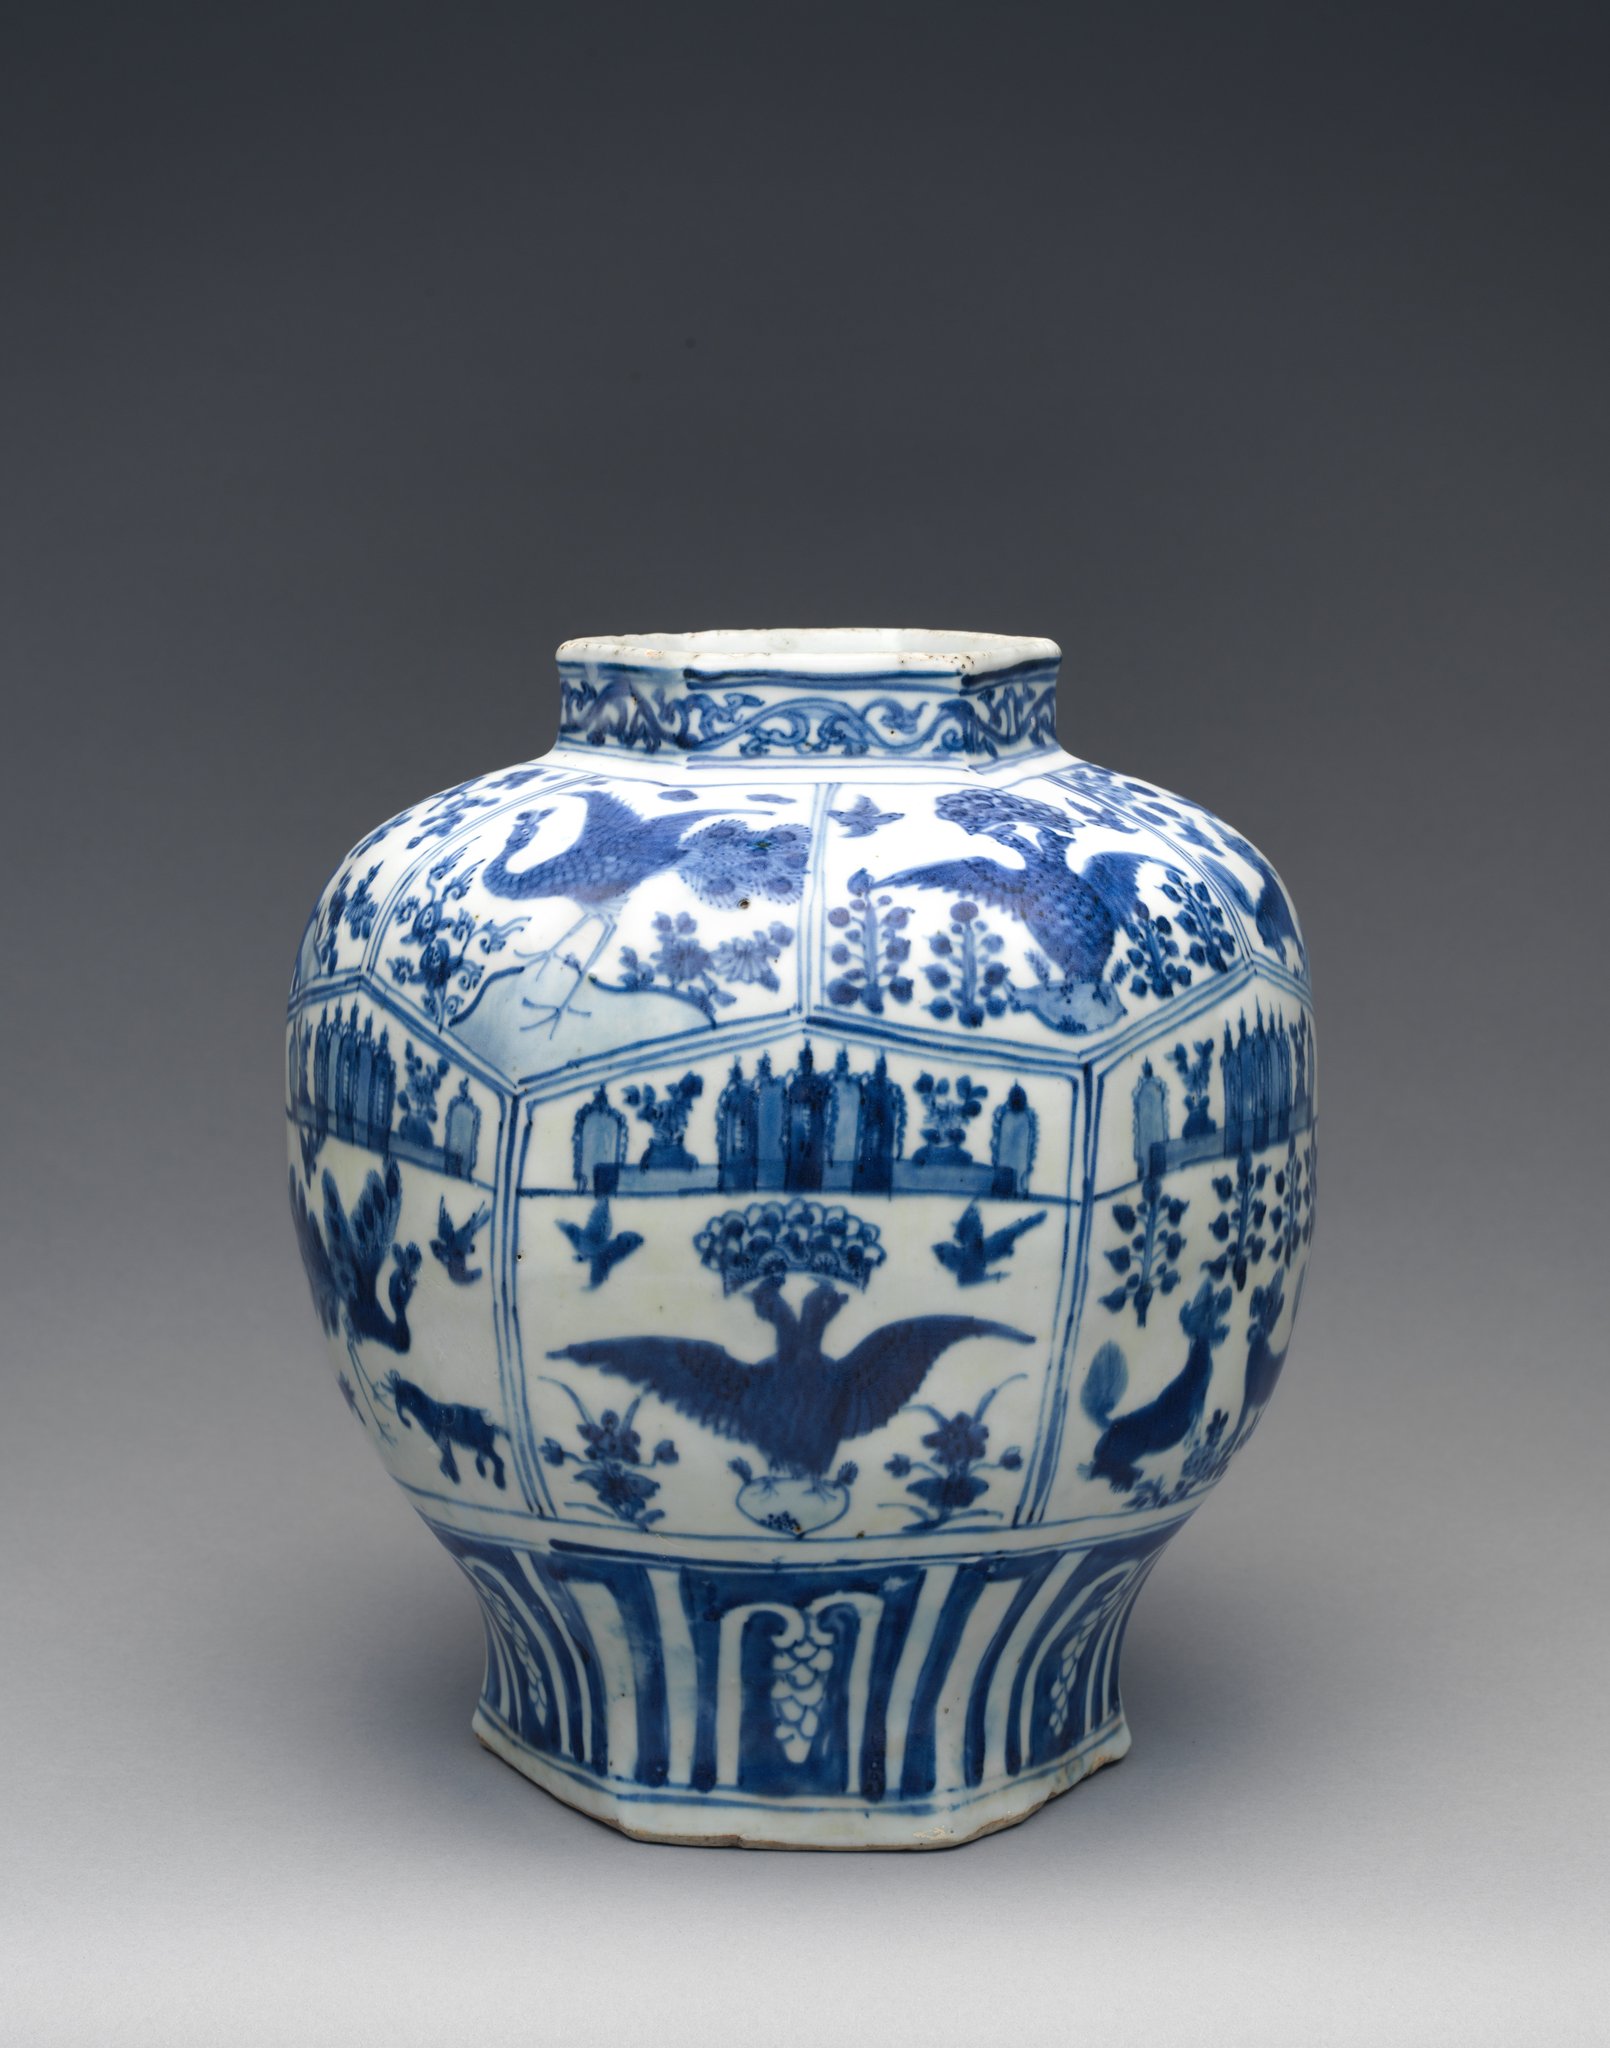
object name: jar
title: Jar with the emblem of the Order of Saint Augustine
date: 1575-1600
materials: cobalt, glaze, porcelain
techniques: painting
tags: birds,eagles,peacocks